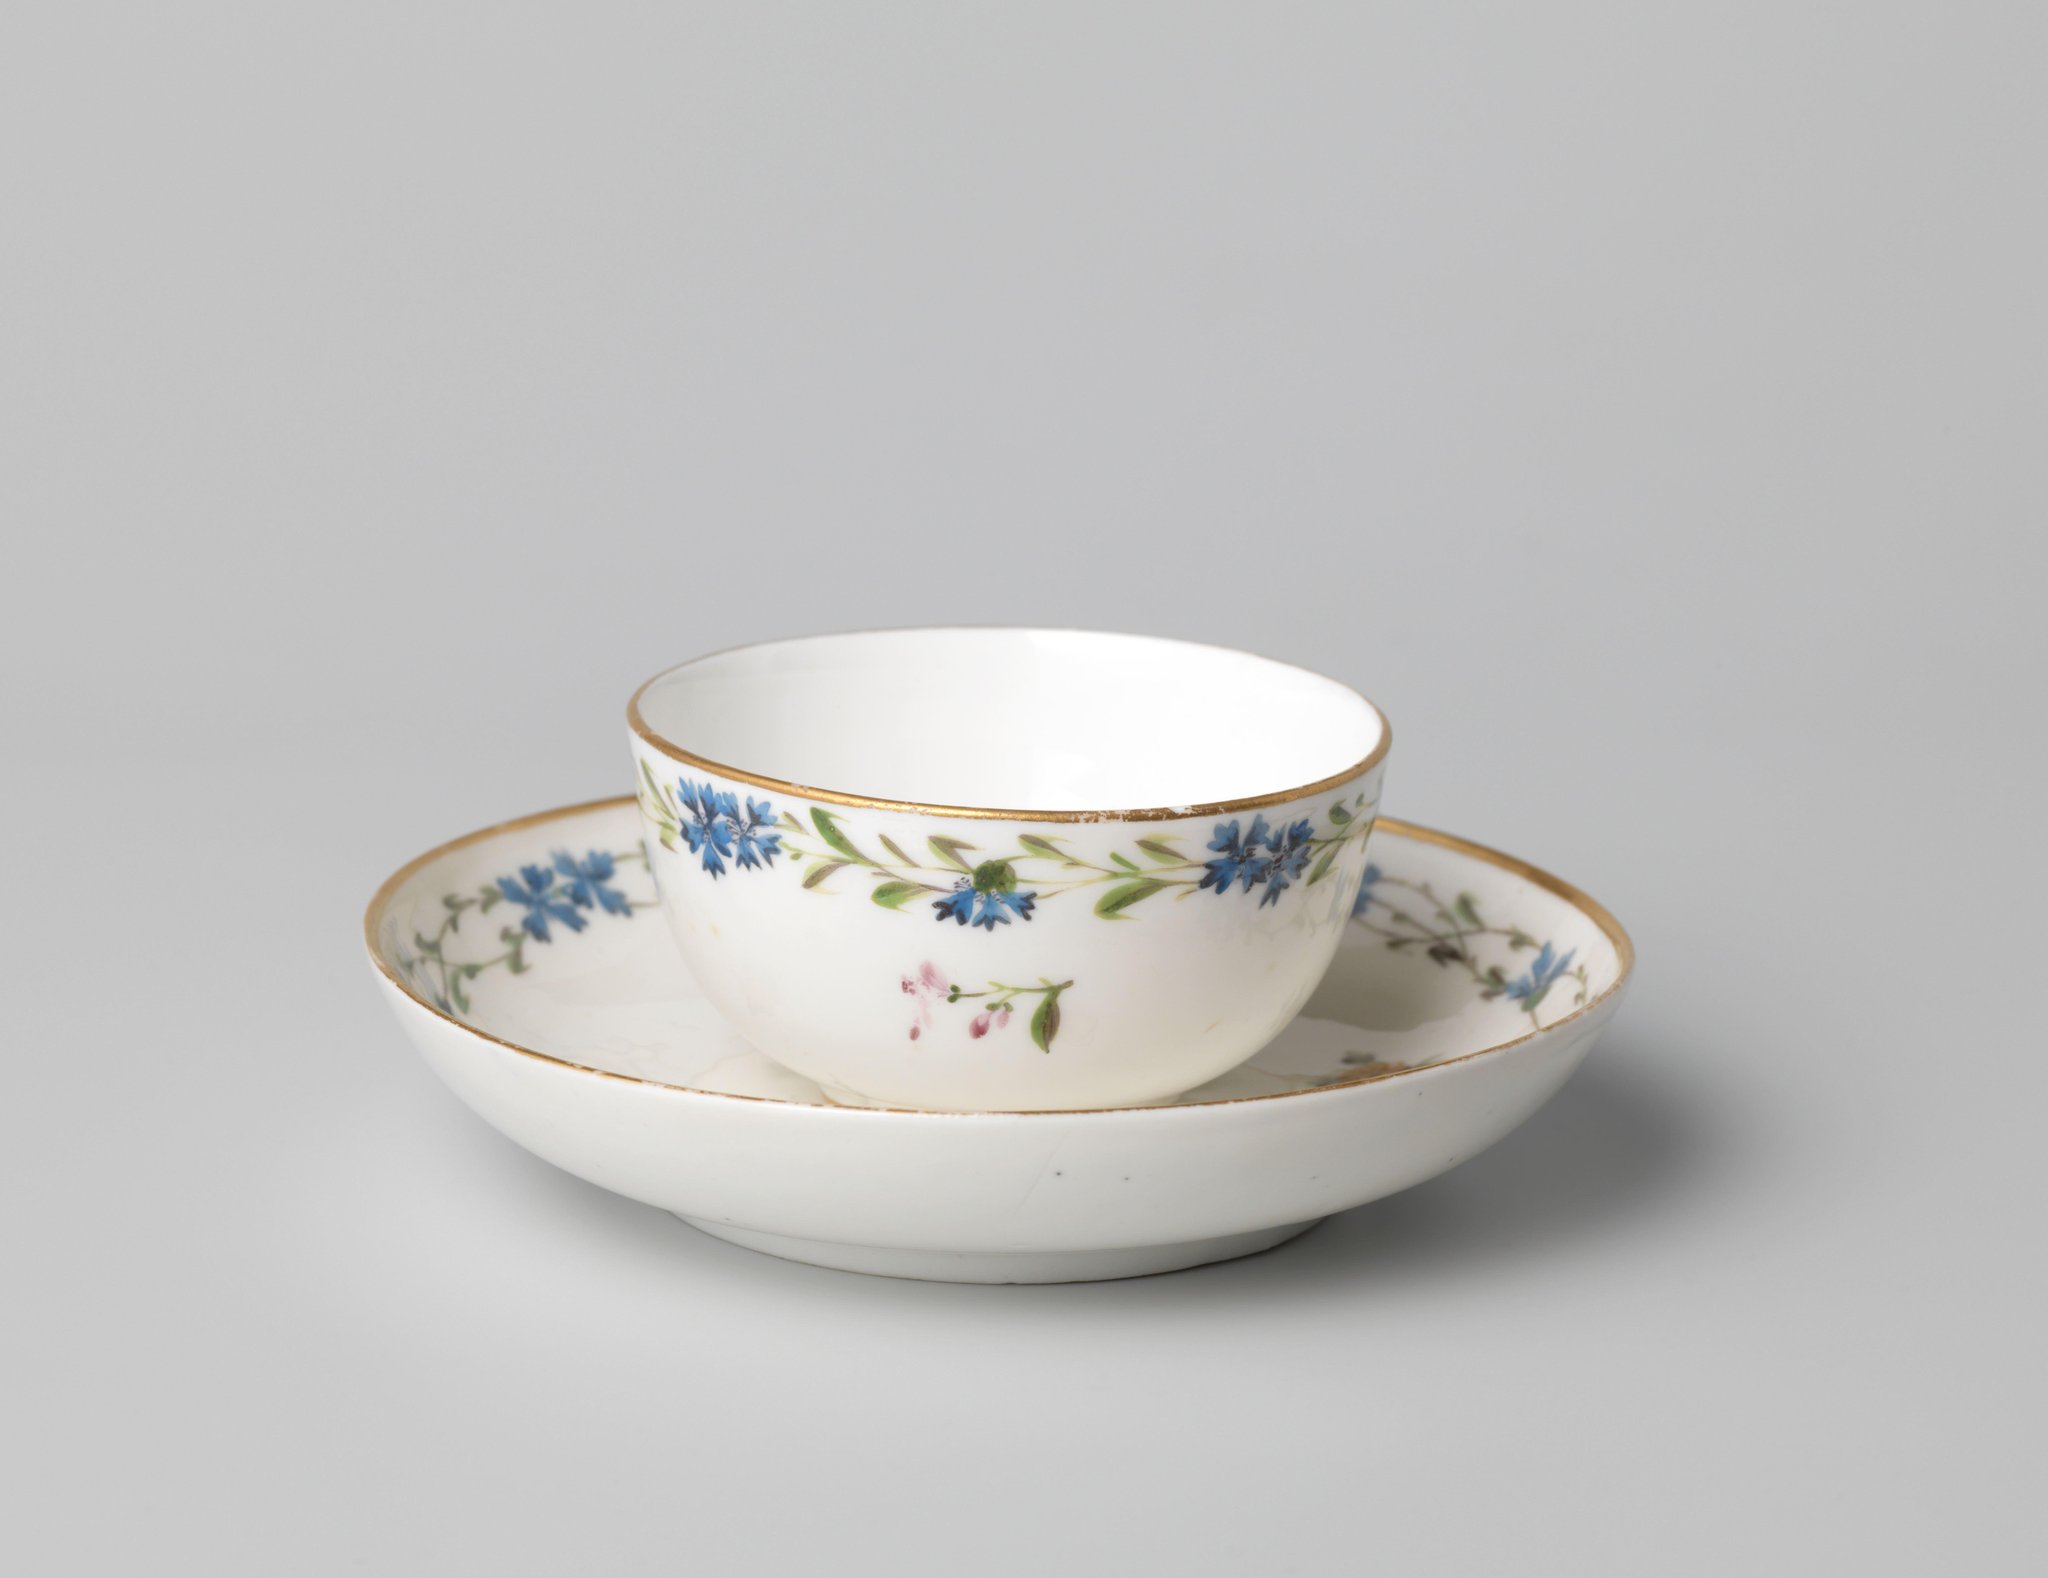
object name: vessel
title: Kop zonder oor en schotel van porselein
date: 1774-1784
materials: porcelain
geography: loosdrecht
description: Tea cup and saucer. Porcelain. Loosdrecht or Ouder-Amstel, c. 1782 - 1786. Factory under direction of Friedrich Daeuber.